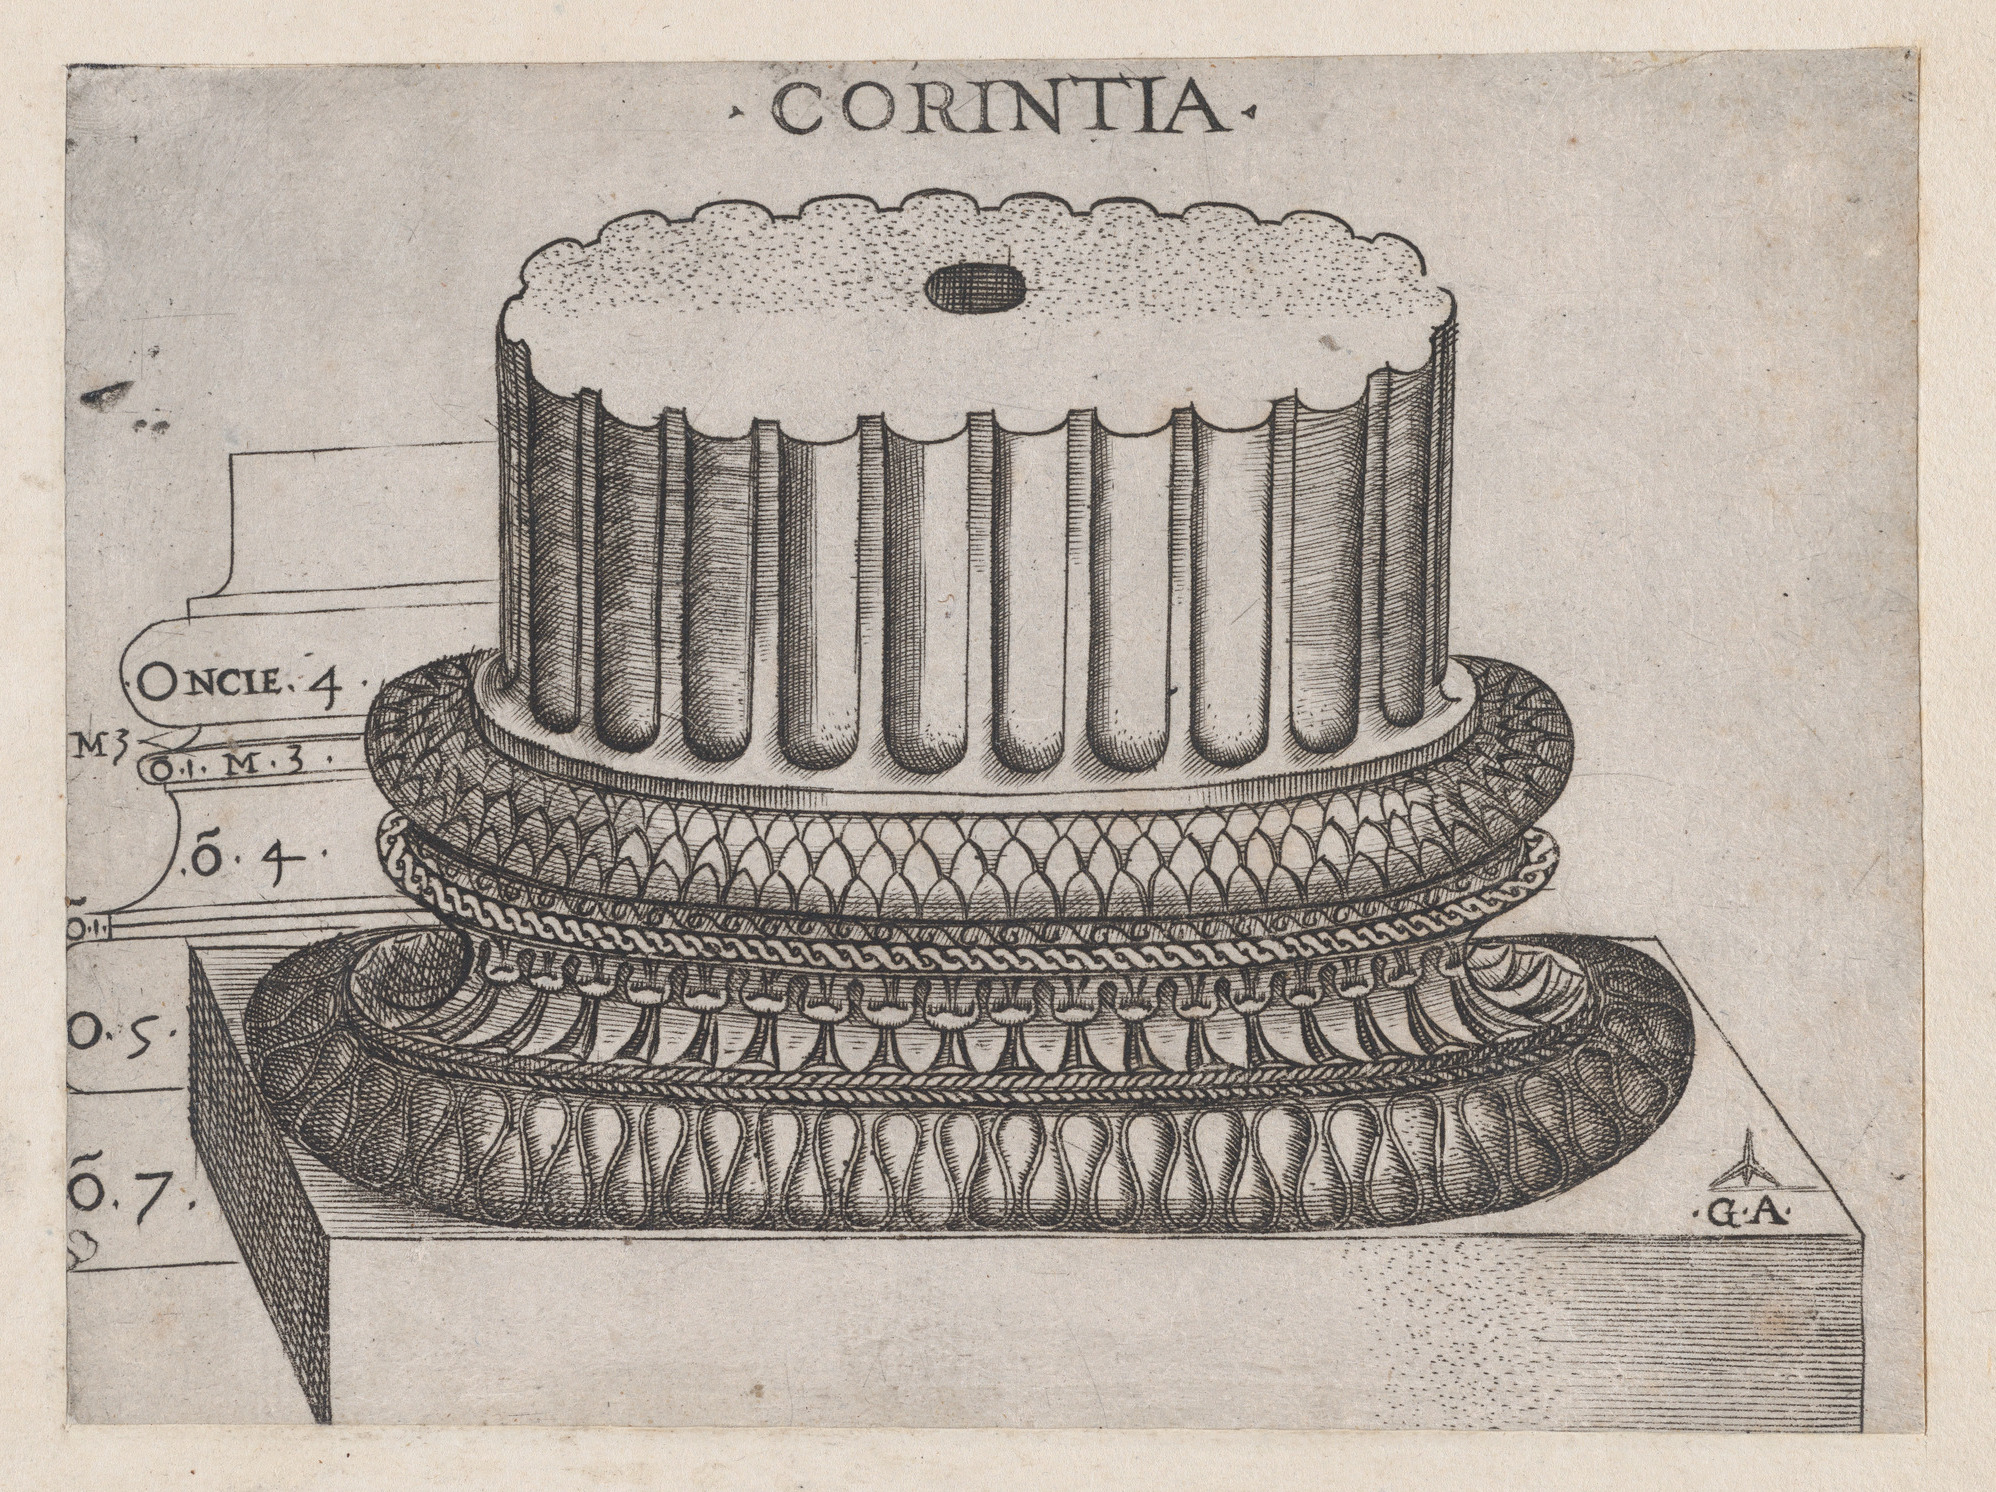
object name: print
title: Corinthian base, from "Speculum Romanae Magnificentiae"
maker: monogrammist g.a. with the caltrop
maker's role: artist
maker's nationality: italian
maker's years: 1535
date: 1537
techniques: engraving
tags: architecture